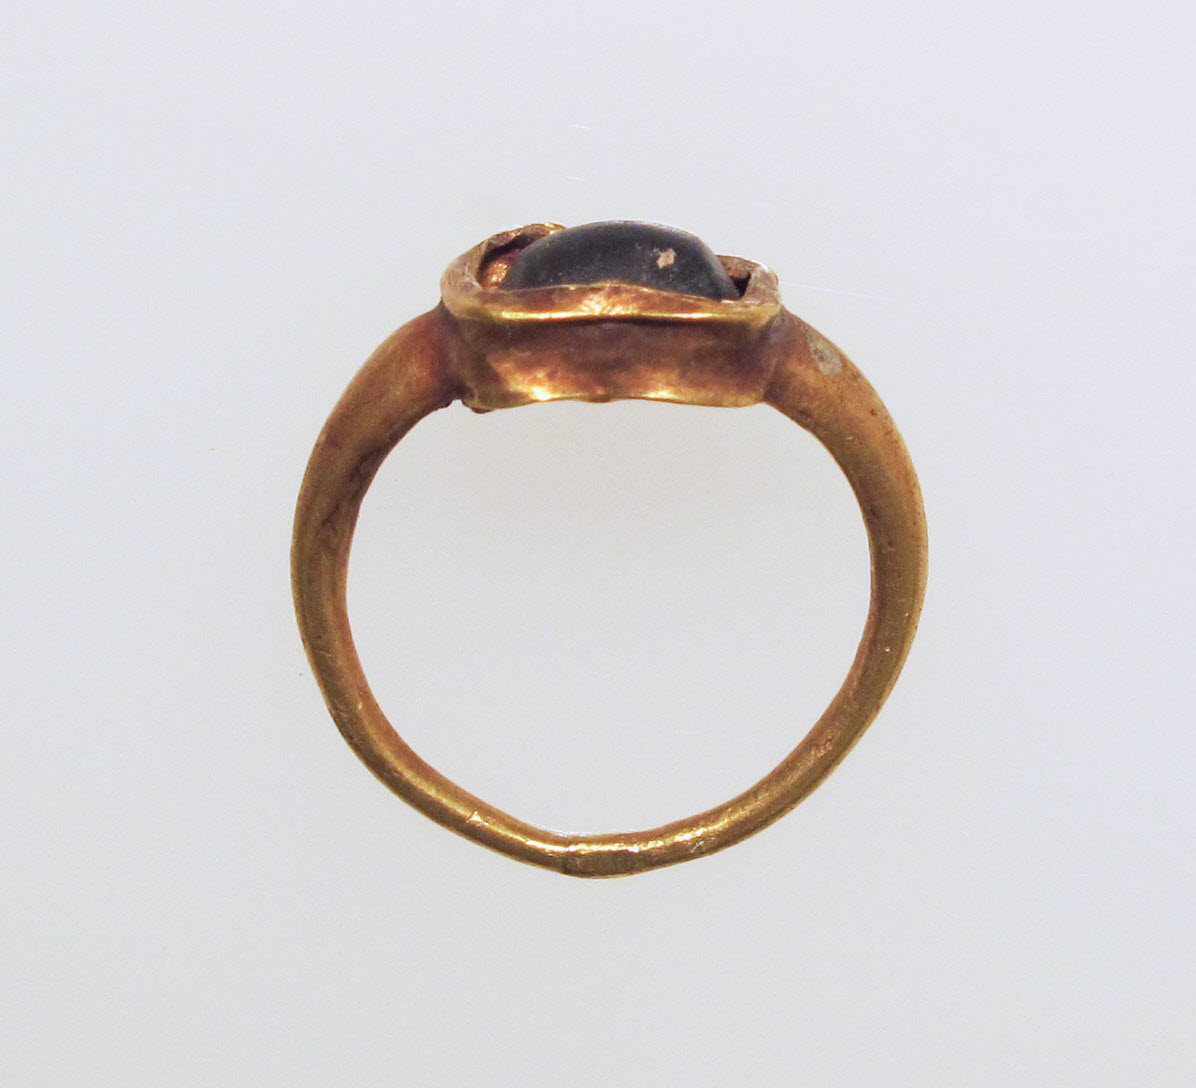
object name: ring with glass bezel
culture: roman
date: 100 BCE-300 CE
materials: glass, gold